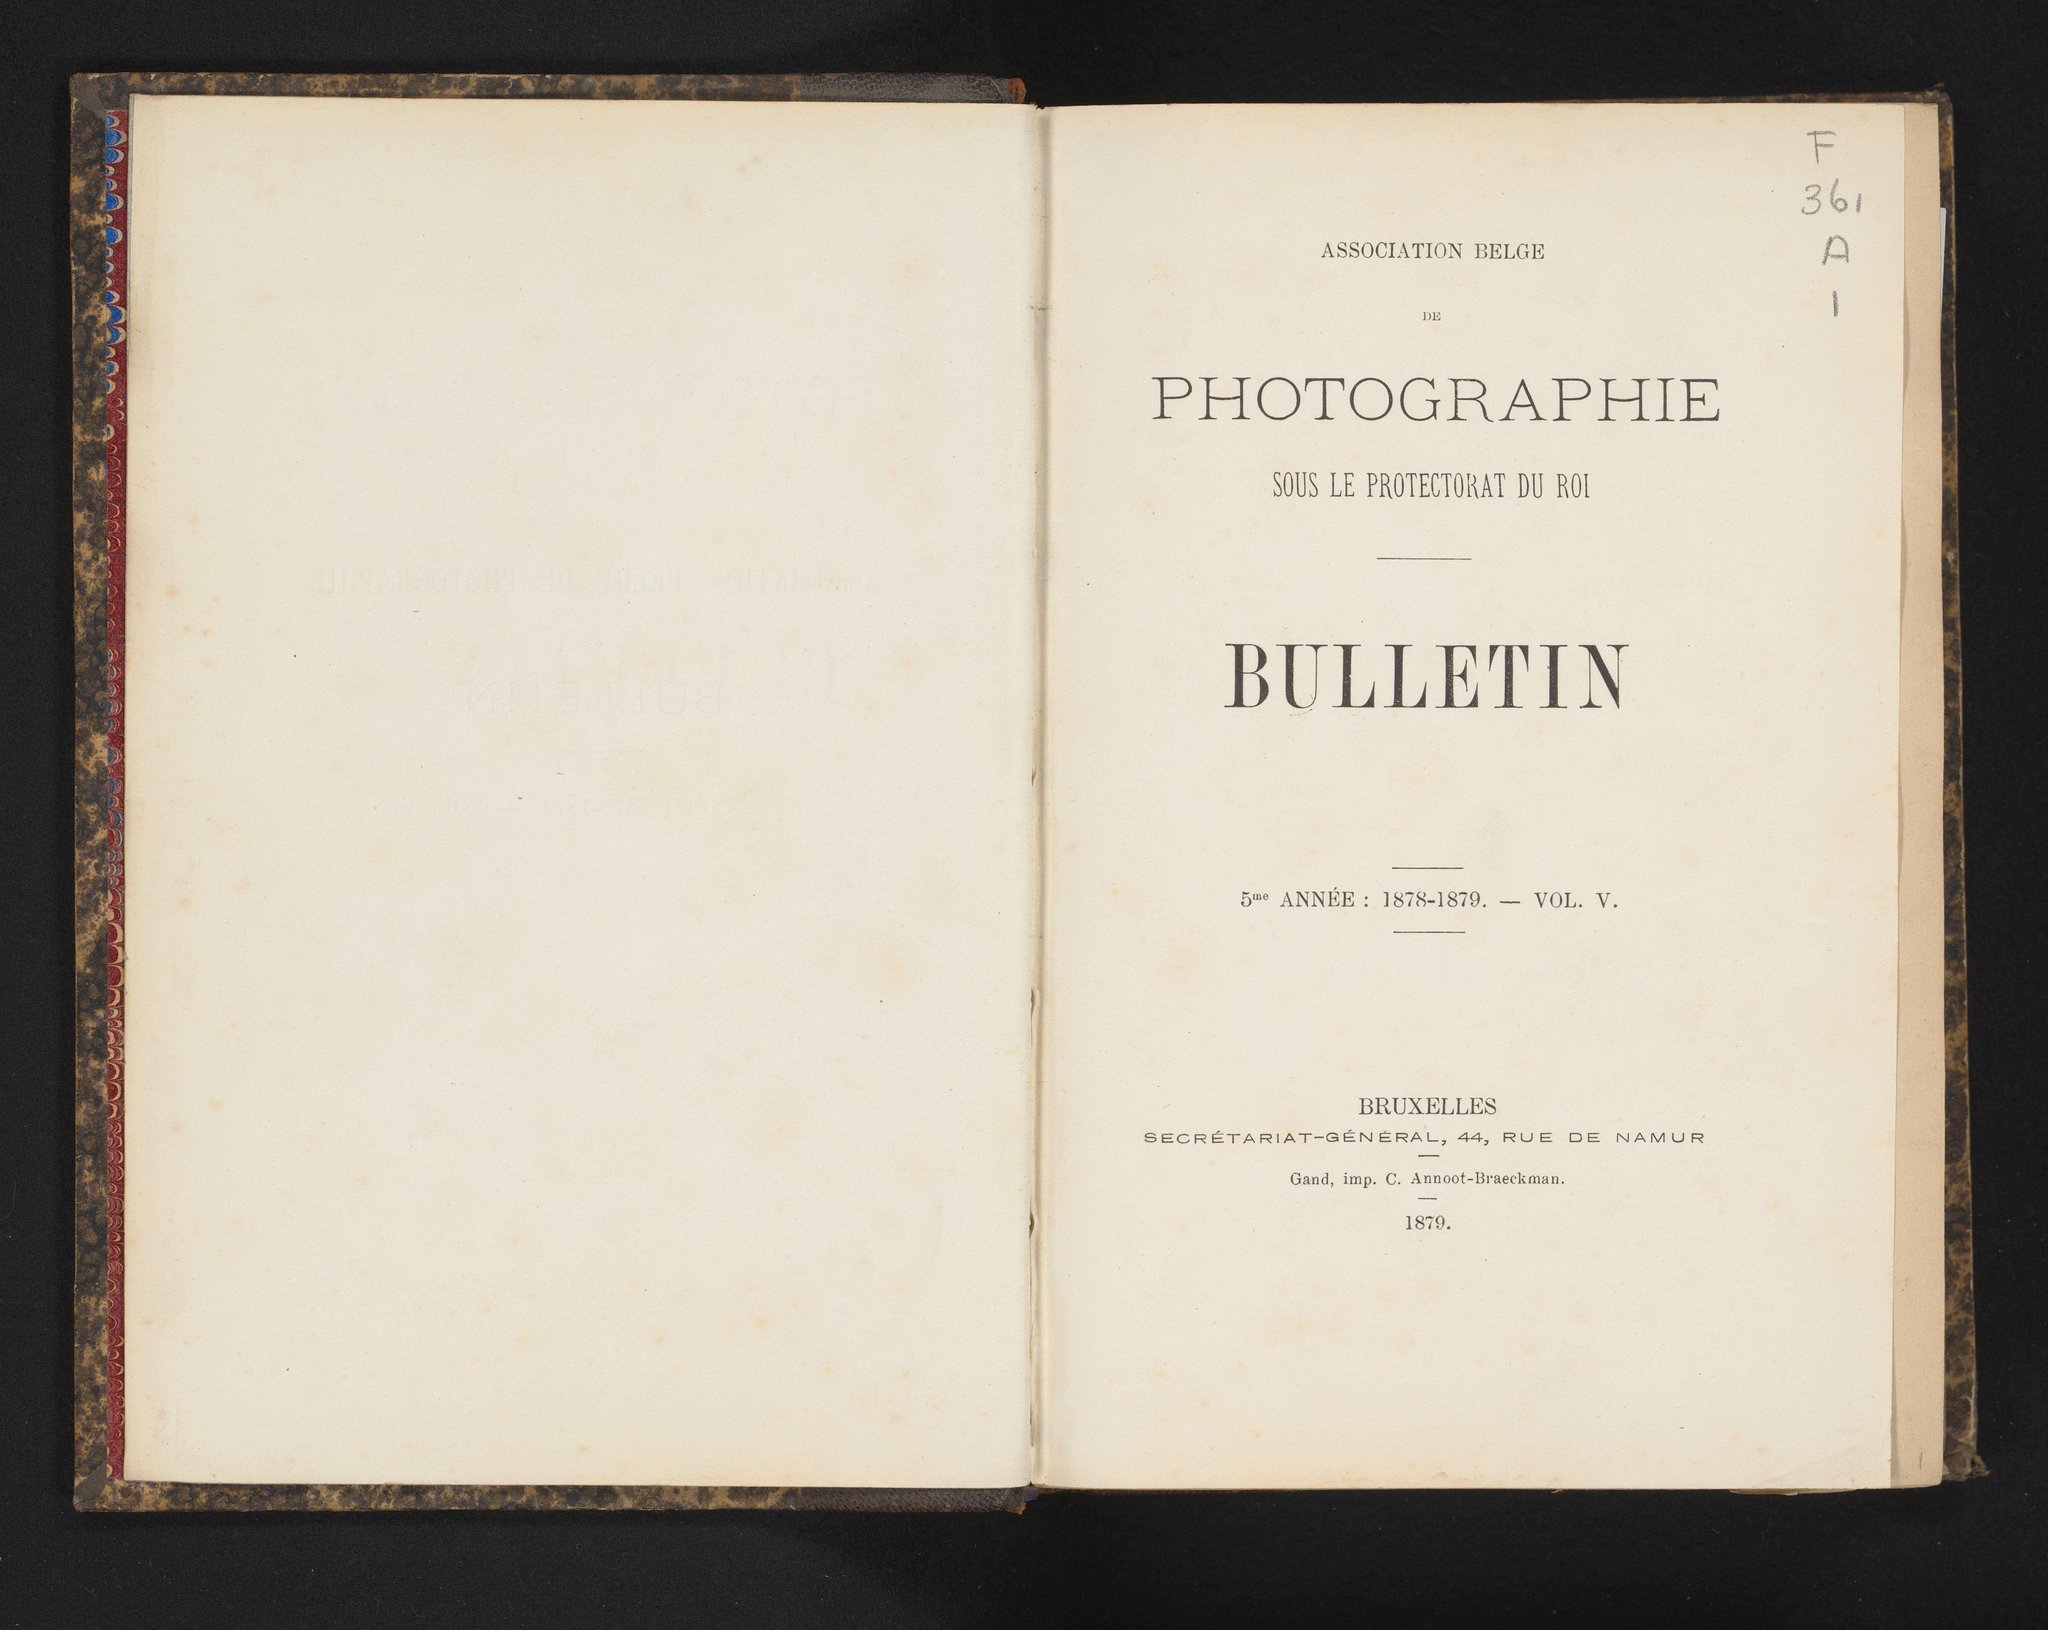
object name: book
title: Bulletin / Association belge de photographie.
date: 1878-1879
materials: cardboard, leather, paper, photographic support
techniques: carbon print, photograph, marbled paper, platinum process, printing, woodburytype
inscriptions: annotation: ‘APR/1998’